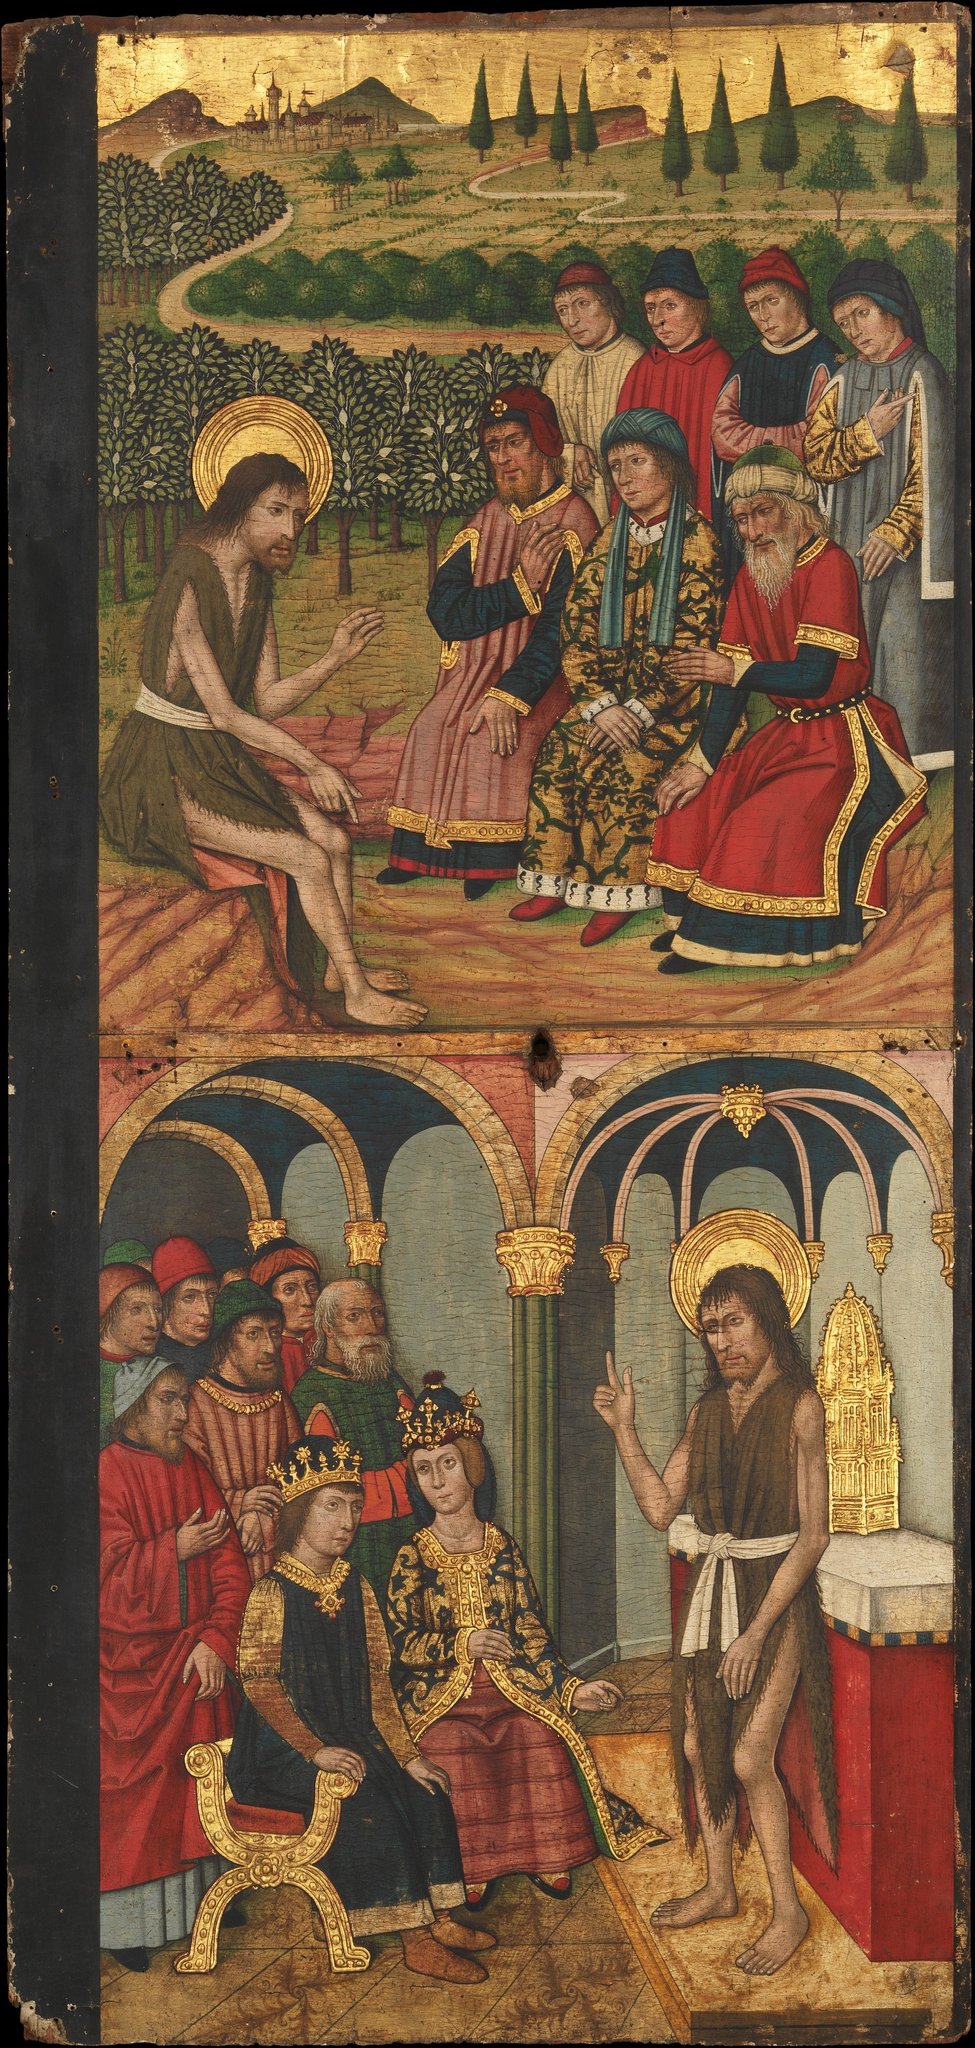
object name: painting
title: Panel of Saint John the Baptist with Scenes from His Life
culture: spanish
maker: domingo ram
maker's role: artist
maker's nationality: spanish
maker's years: 1464-1507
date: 1464-1507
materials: gold leaf, paint, wood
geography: spain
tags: men,women,saint john the baptist,herod